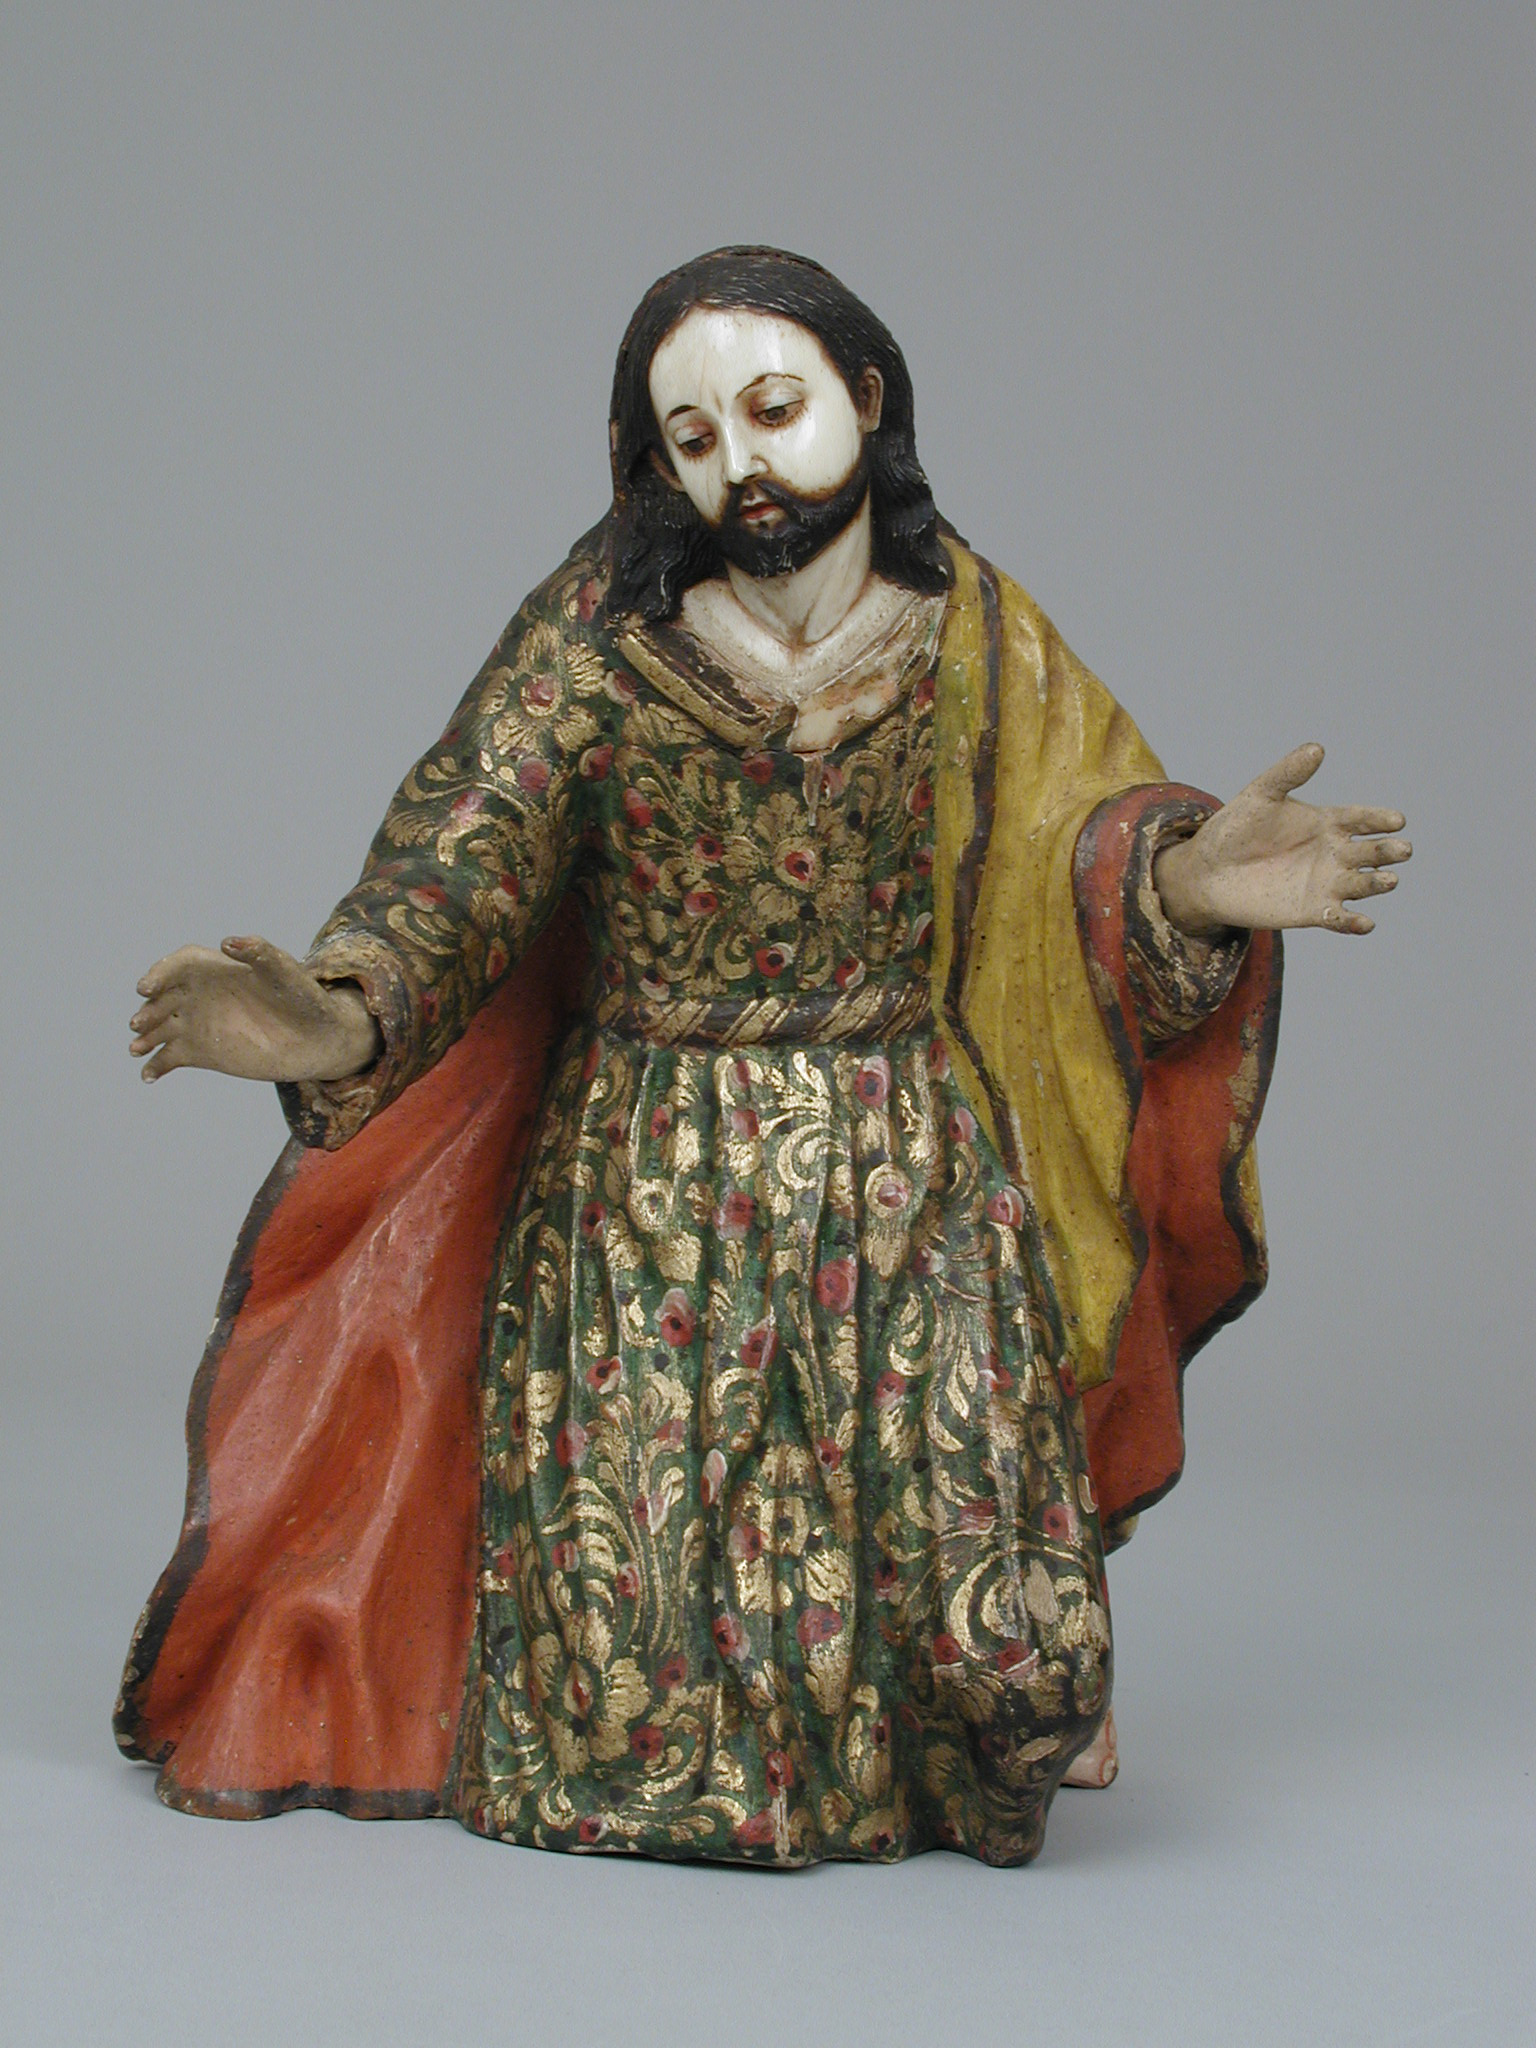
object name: statuette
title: Joseph (from a nativity)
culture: ecuadorian or philippine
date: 1701-1800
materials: ivory, wood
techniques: gilding, polychrome, polychromy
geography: philippines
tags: saint joseph